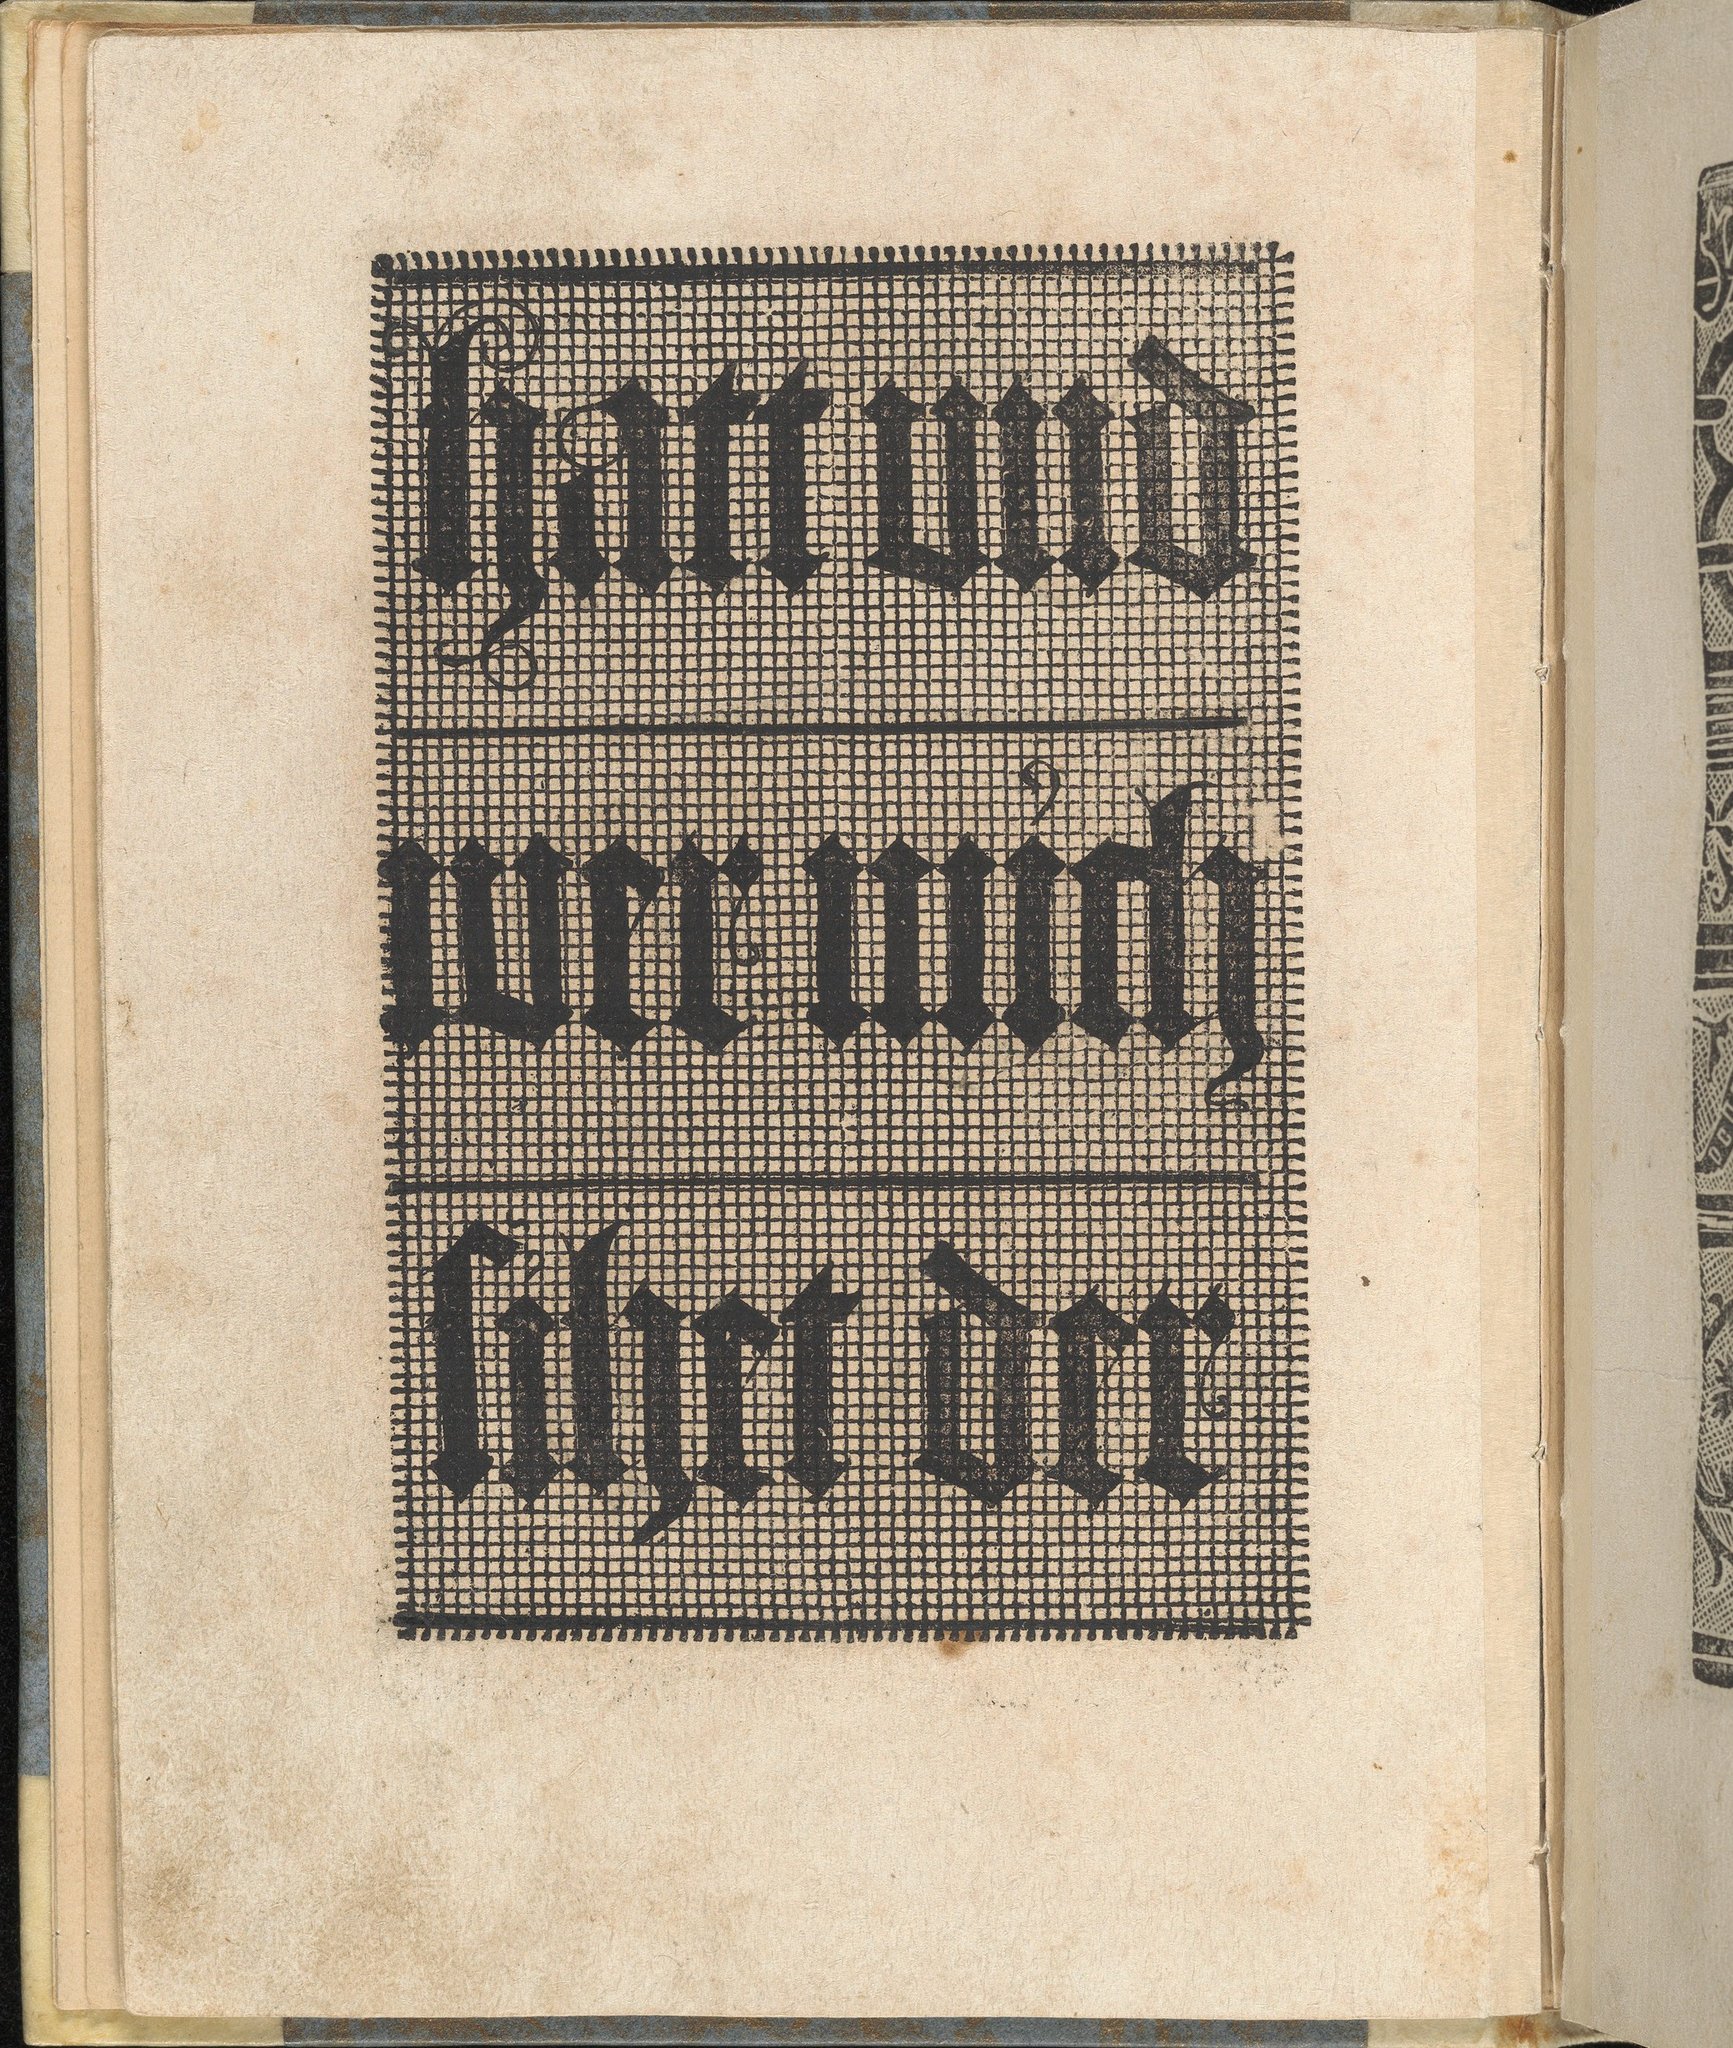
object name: book print ornament architecture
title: Ein ney Furmbüchlein, Page 10, verso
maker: johann schönsperger the younger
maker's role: publisher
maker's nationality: german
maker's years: 1490-1550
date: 1525-1529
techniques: woodcut